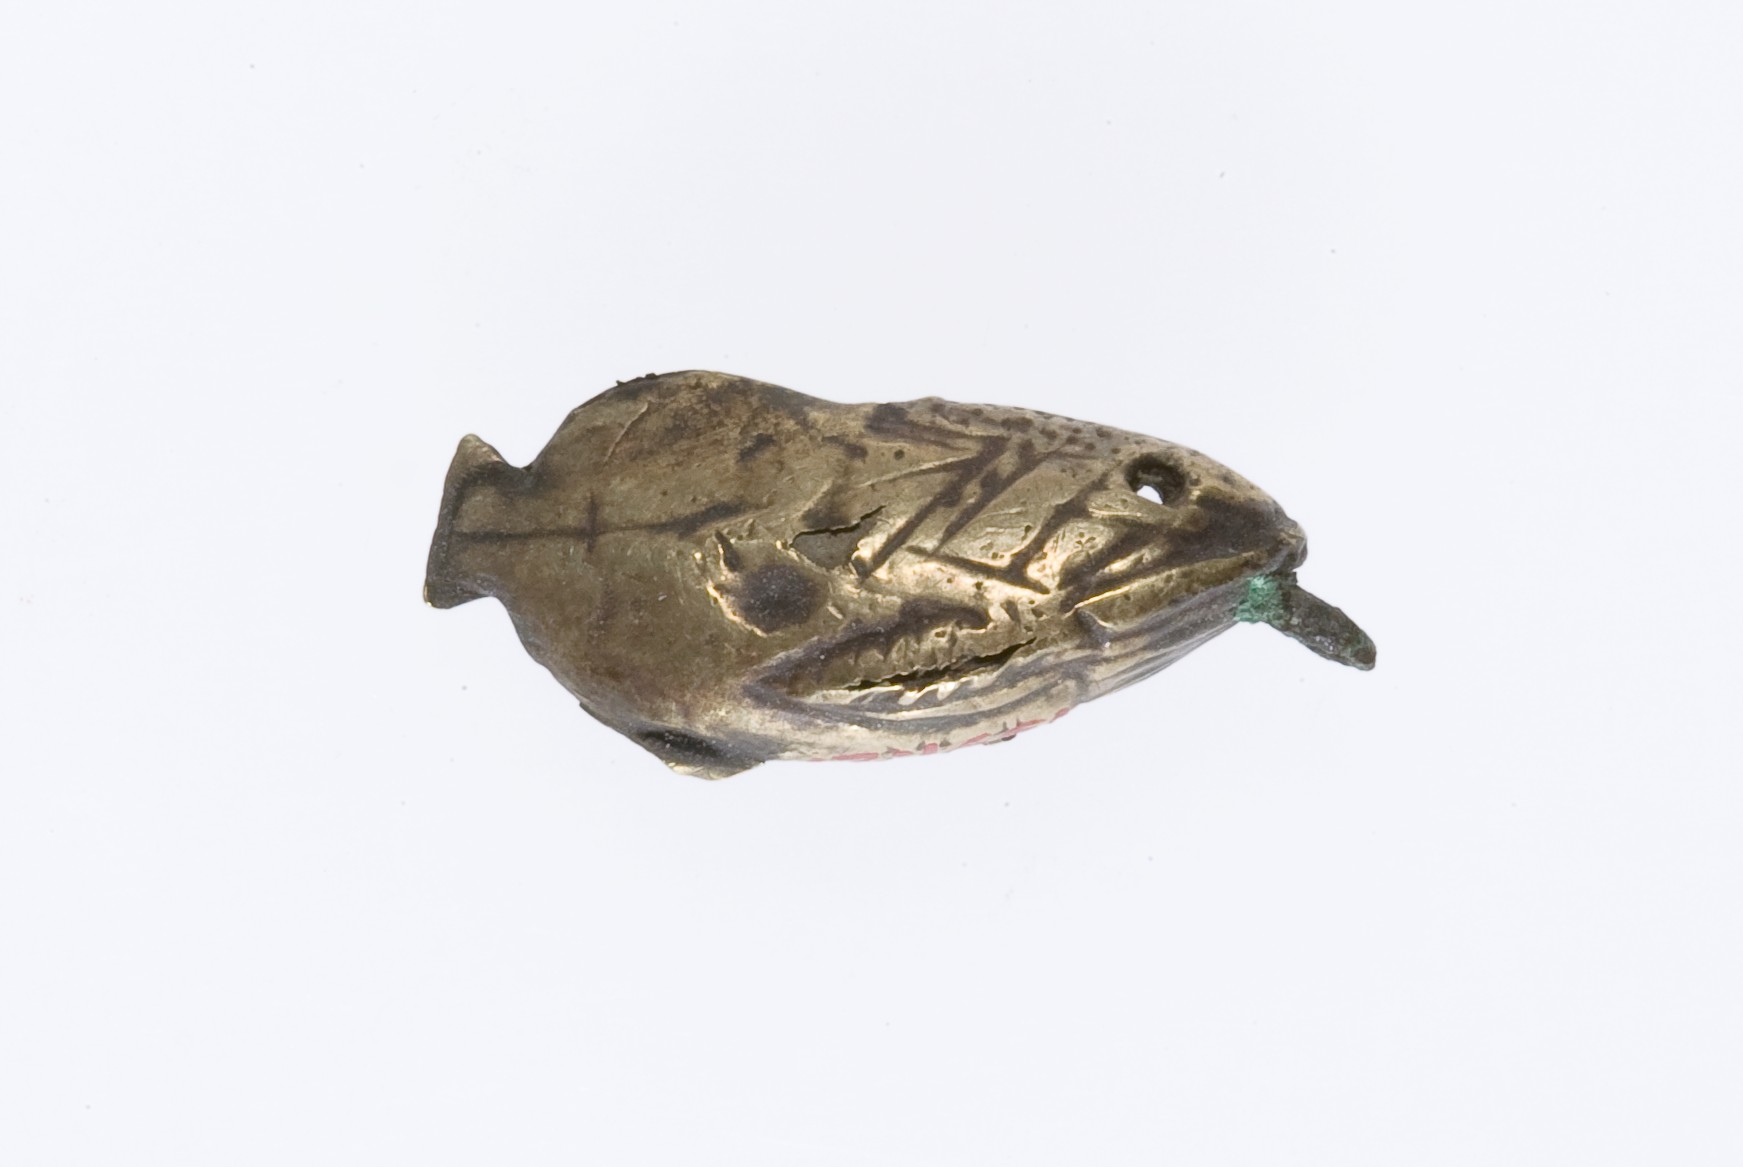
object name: pendant, fish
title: Fish pendant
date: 1981-1650 BCE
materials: gold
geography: egypt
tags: fish